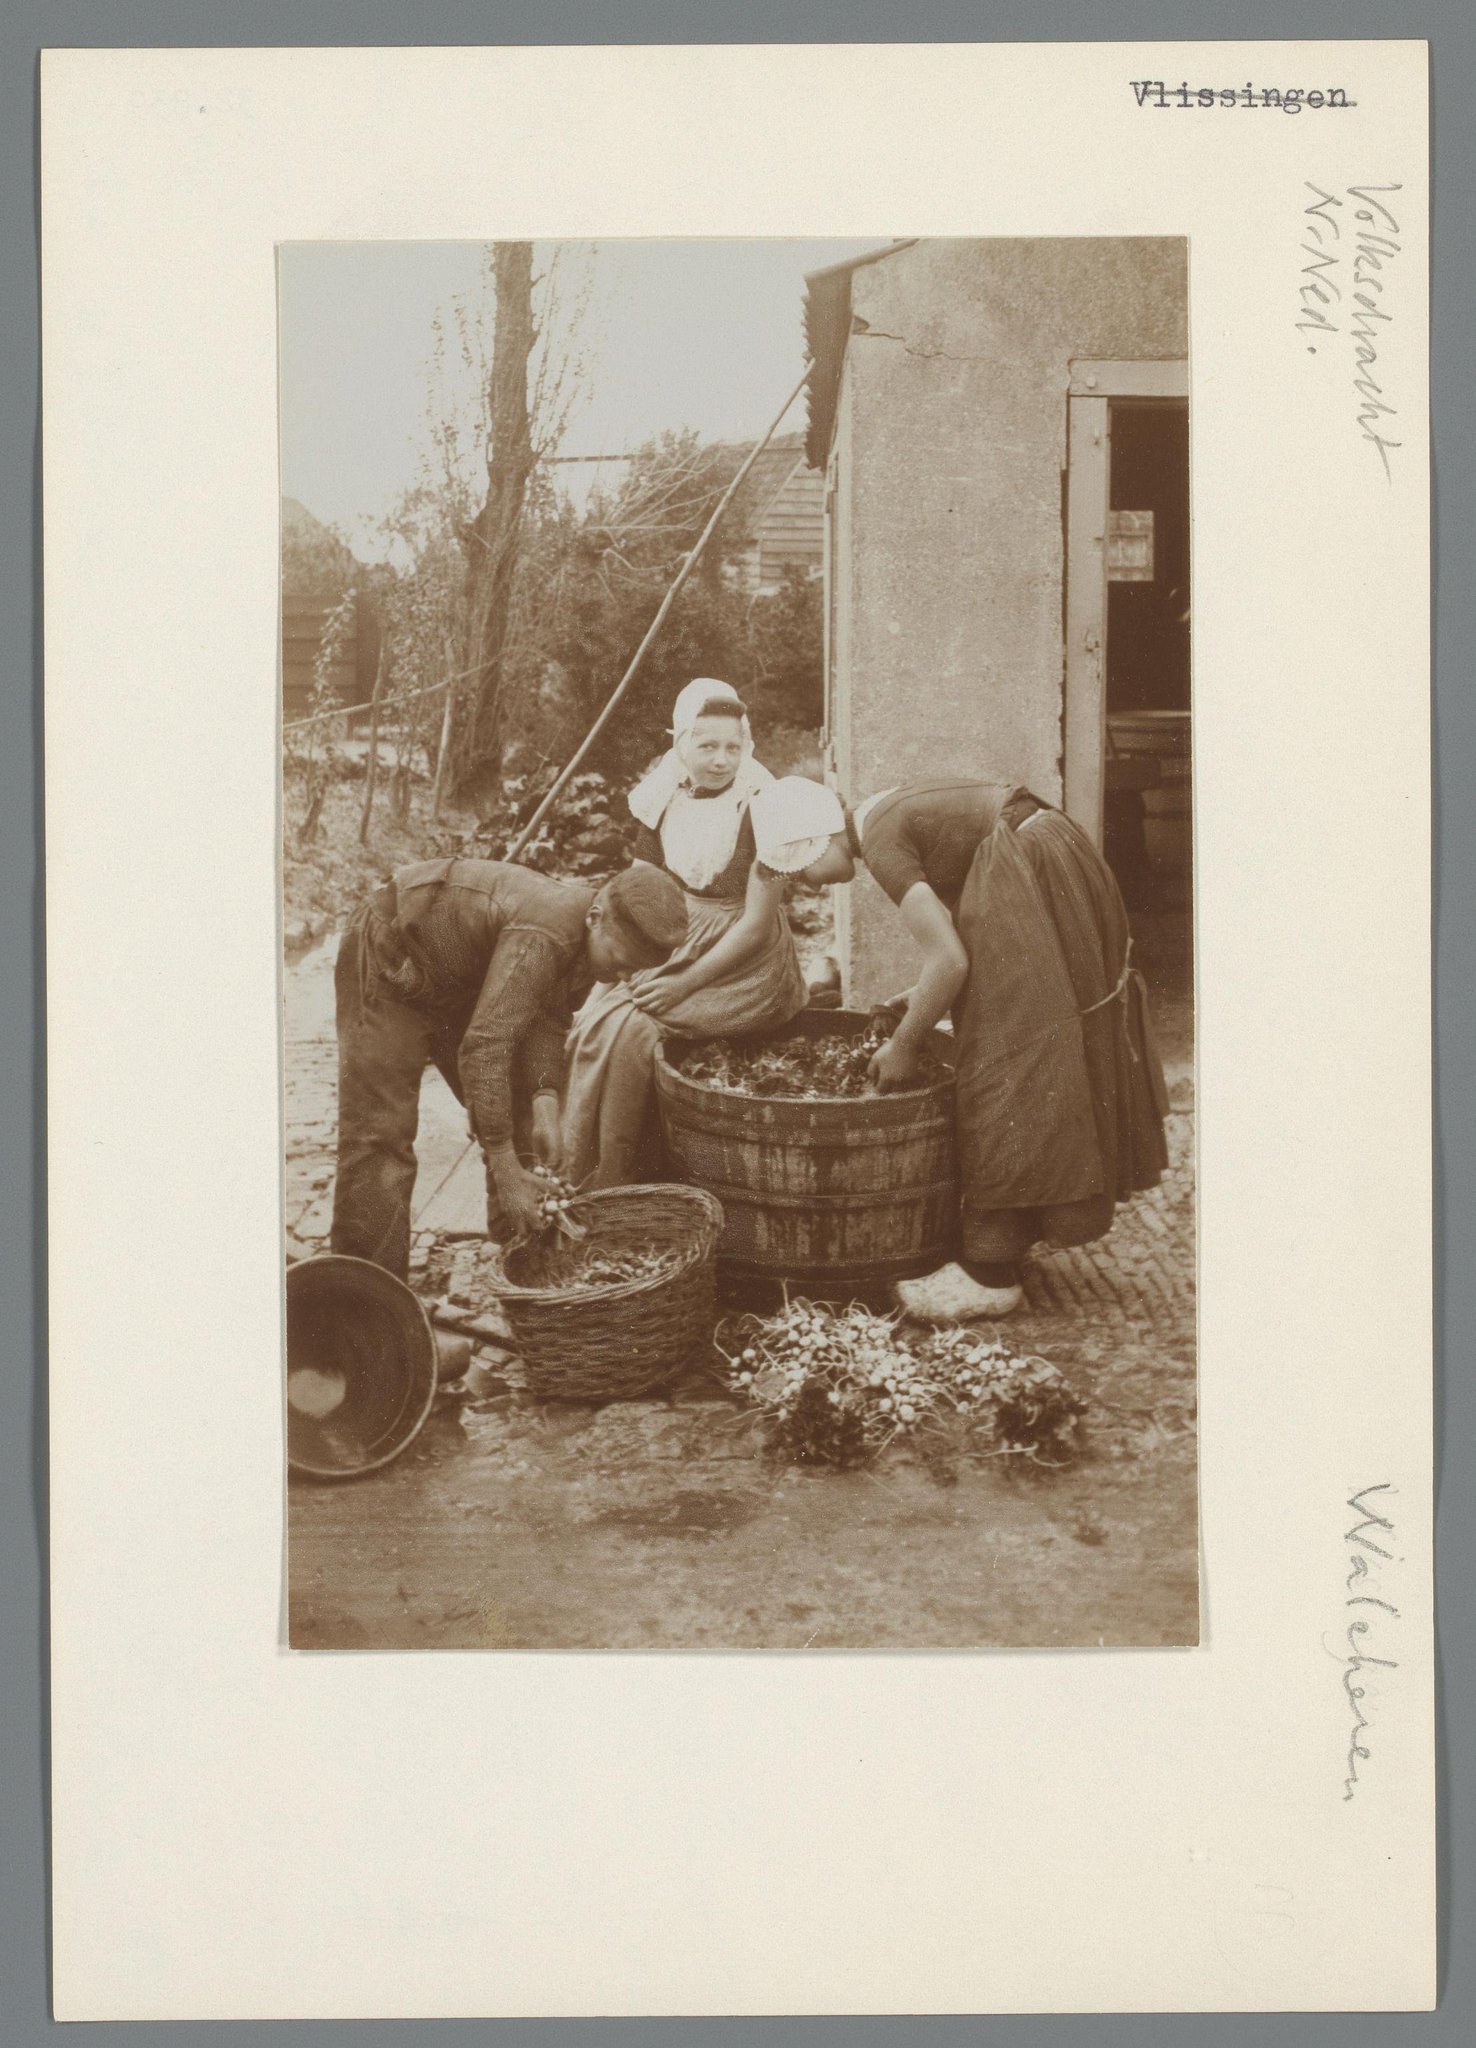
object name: photograph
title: Vlissingen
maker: Anonymous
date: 1880-1920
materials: paper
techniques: collodion silver print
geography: walcheren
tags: historical persons, folk costume, regional costume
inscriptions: number: ‘- 527078’, inscription: ‘Volksdracht/ N.Ned./ Walcheren’, number: ‘32.839’